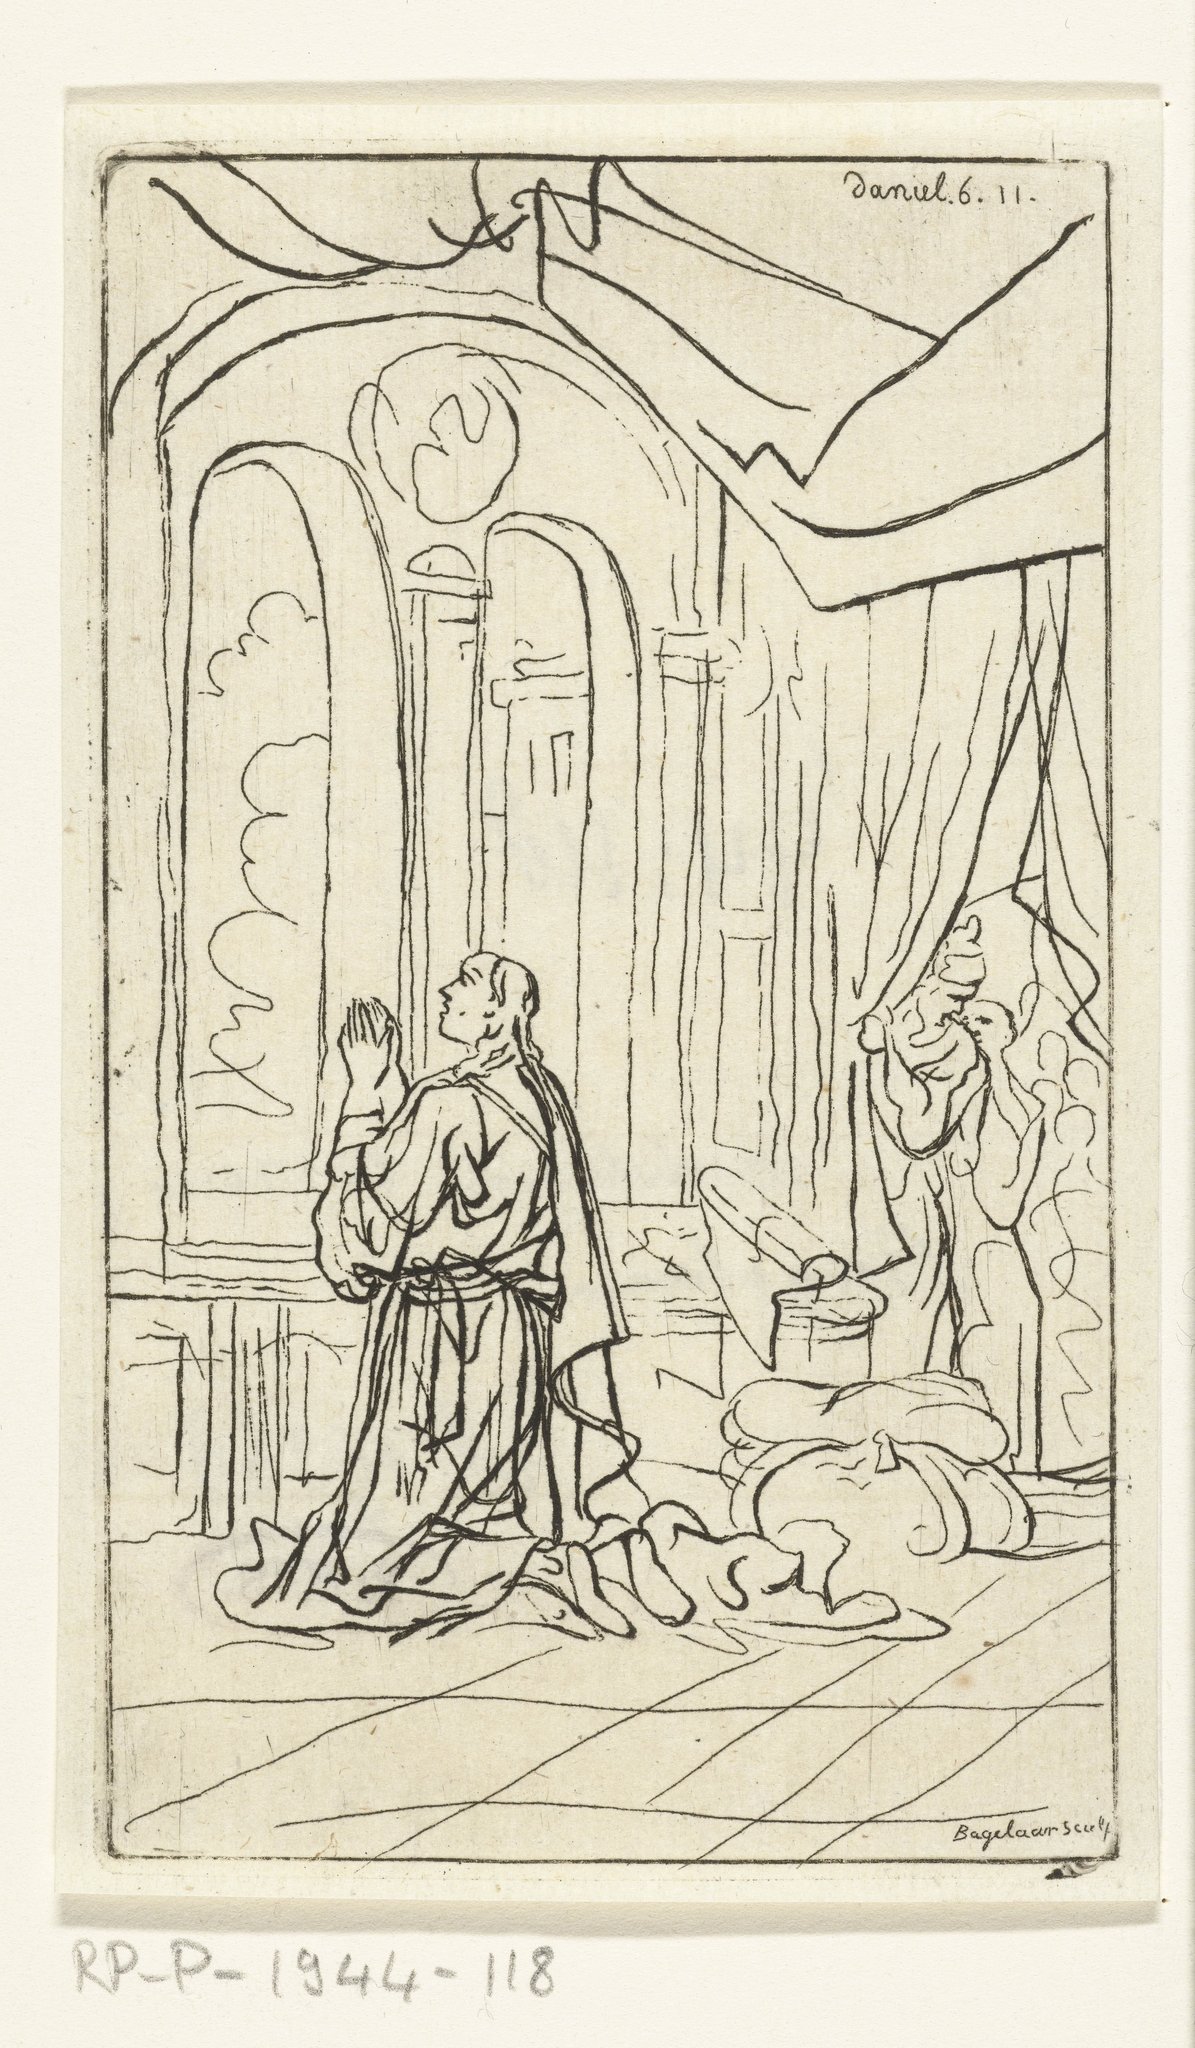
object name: print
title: Daniël geknield voor een venster wordt bespied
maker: ernst willem jan bagelaar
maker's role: draughtsman, print maker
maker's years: 1775-1837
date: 1798-1837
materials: paper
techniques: etching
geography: netherlands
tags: daniel, while praying on his knees before an open window, is discovered by the conspirators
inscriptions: collector's mark: Lugt 2228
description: naar tekening in het Amsterdams Historisch Museum, inv.no. TA49882